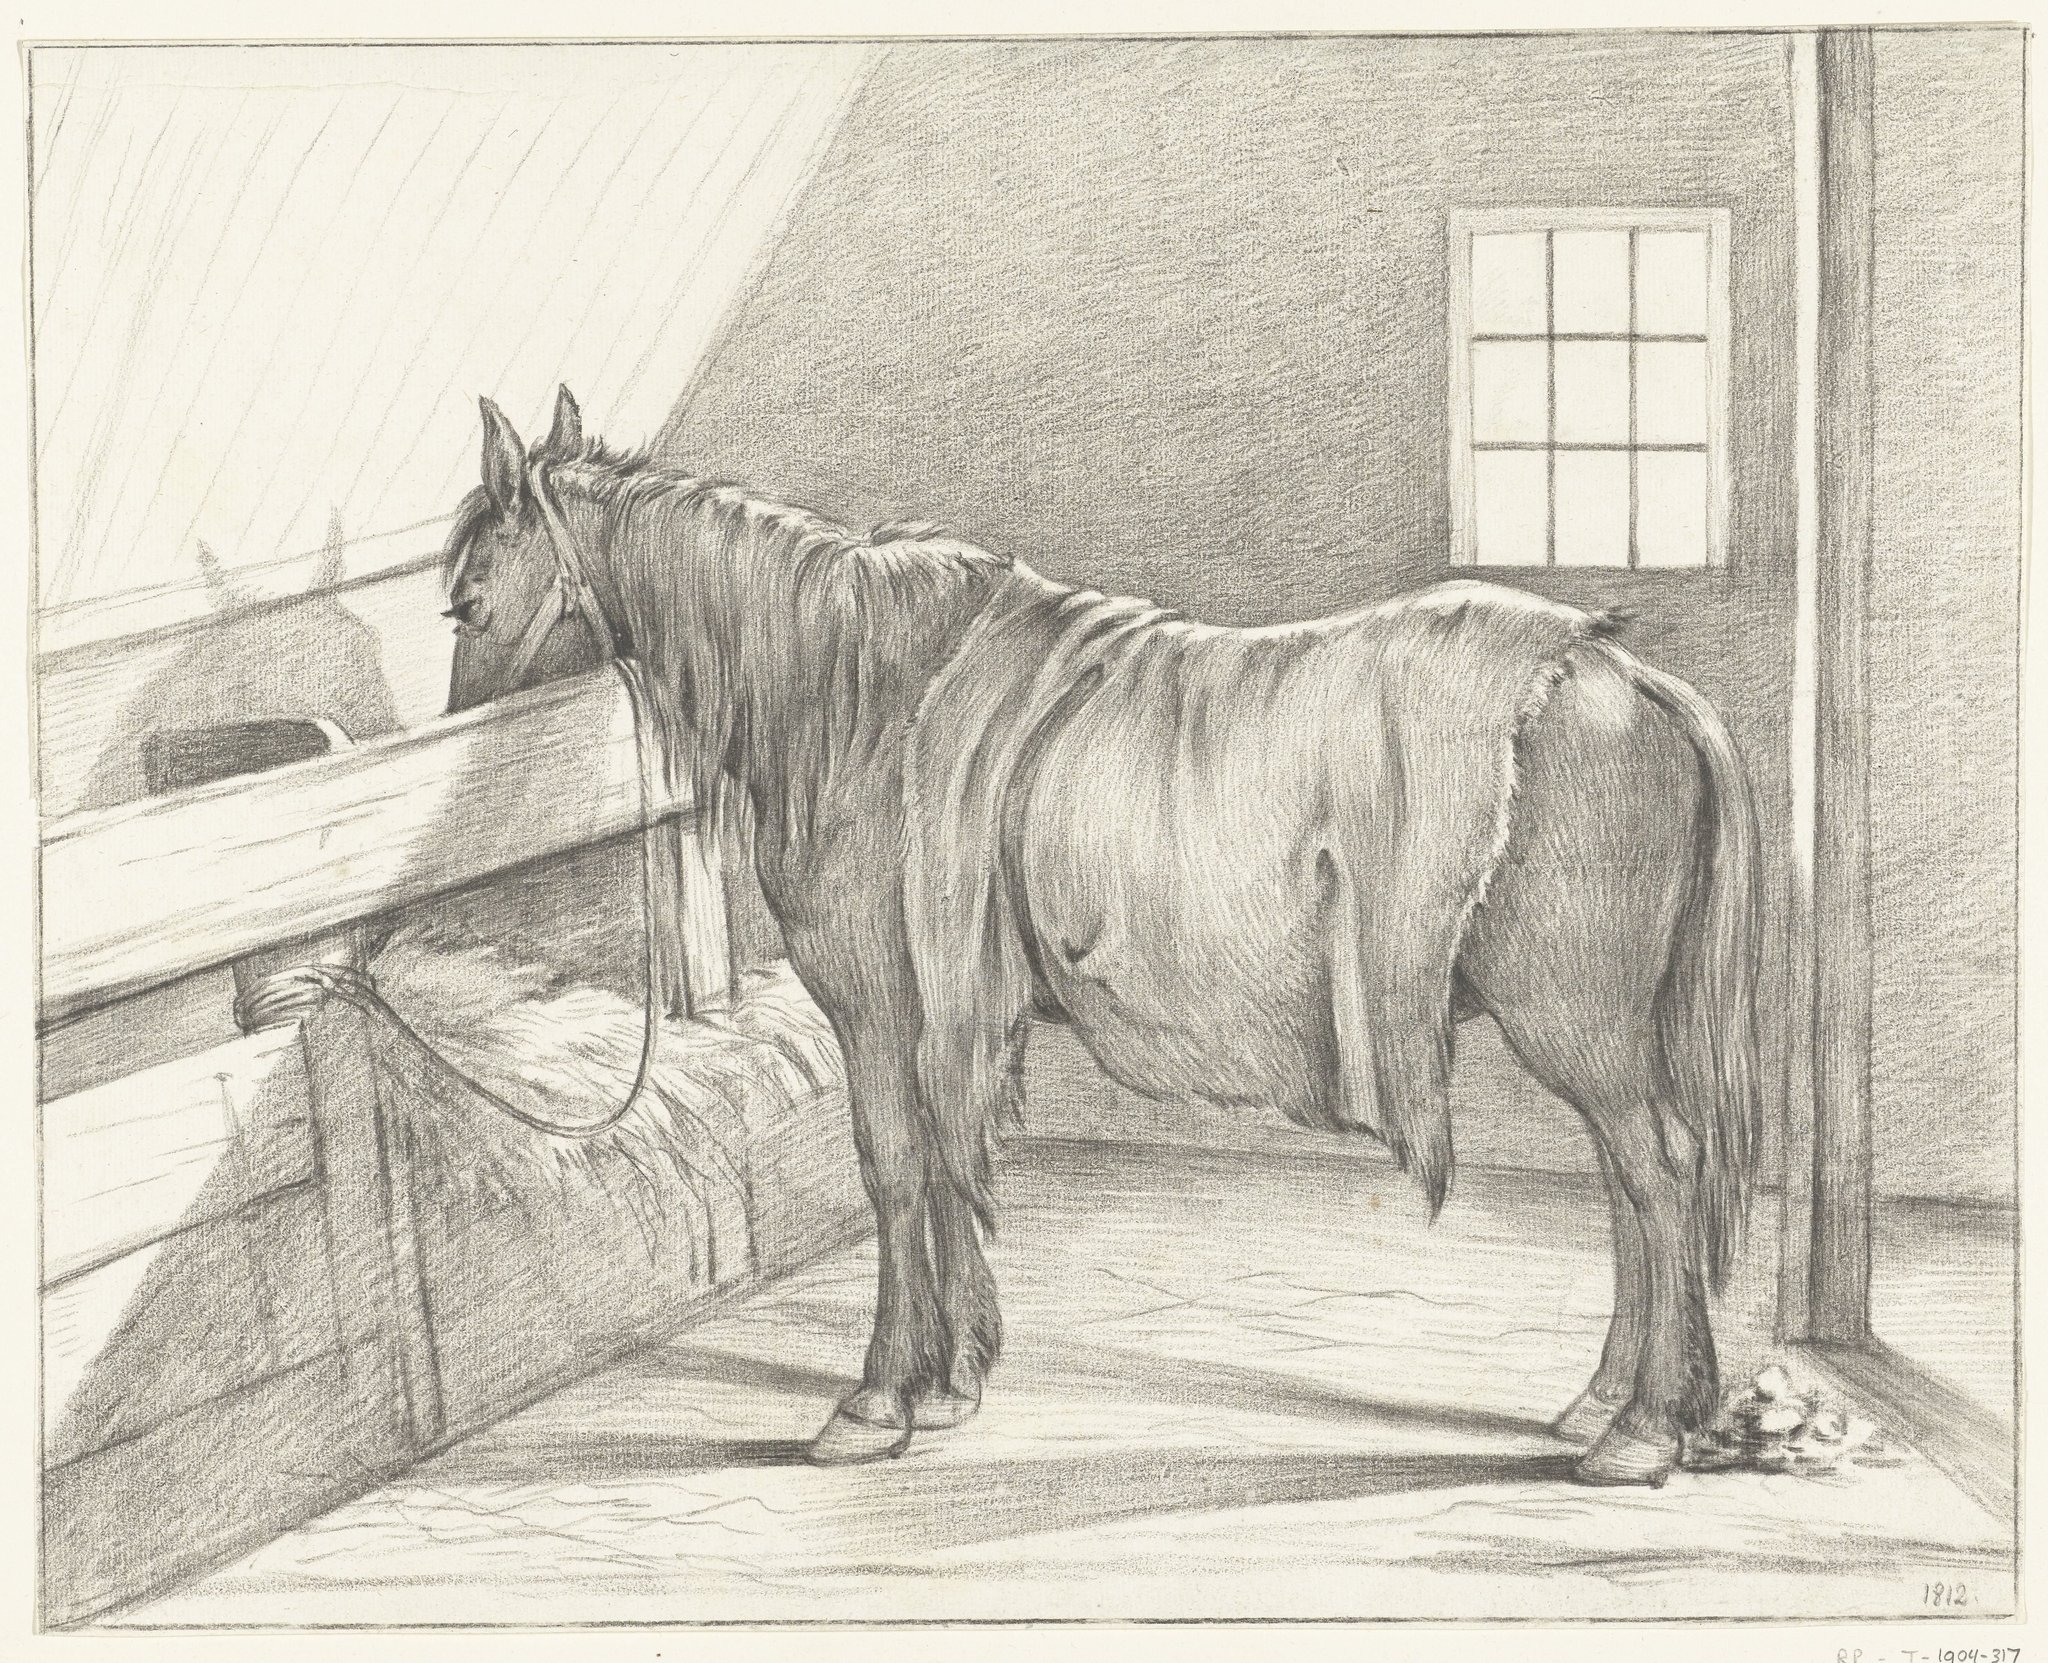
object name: drawing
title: Staand paard in een stal, naar links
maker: jean bernard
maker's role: draughtsman, print maker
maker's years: 1765-1833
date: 1812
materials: chalk, paper, pencil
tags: horse